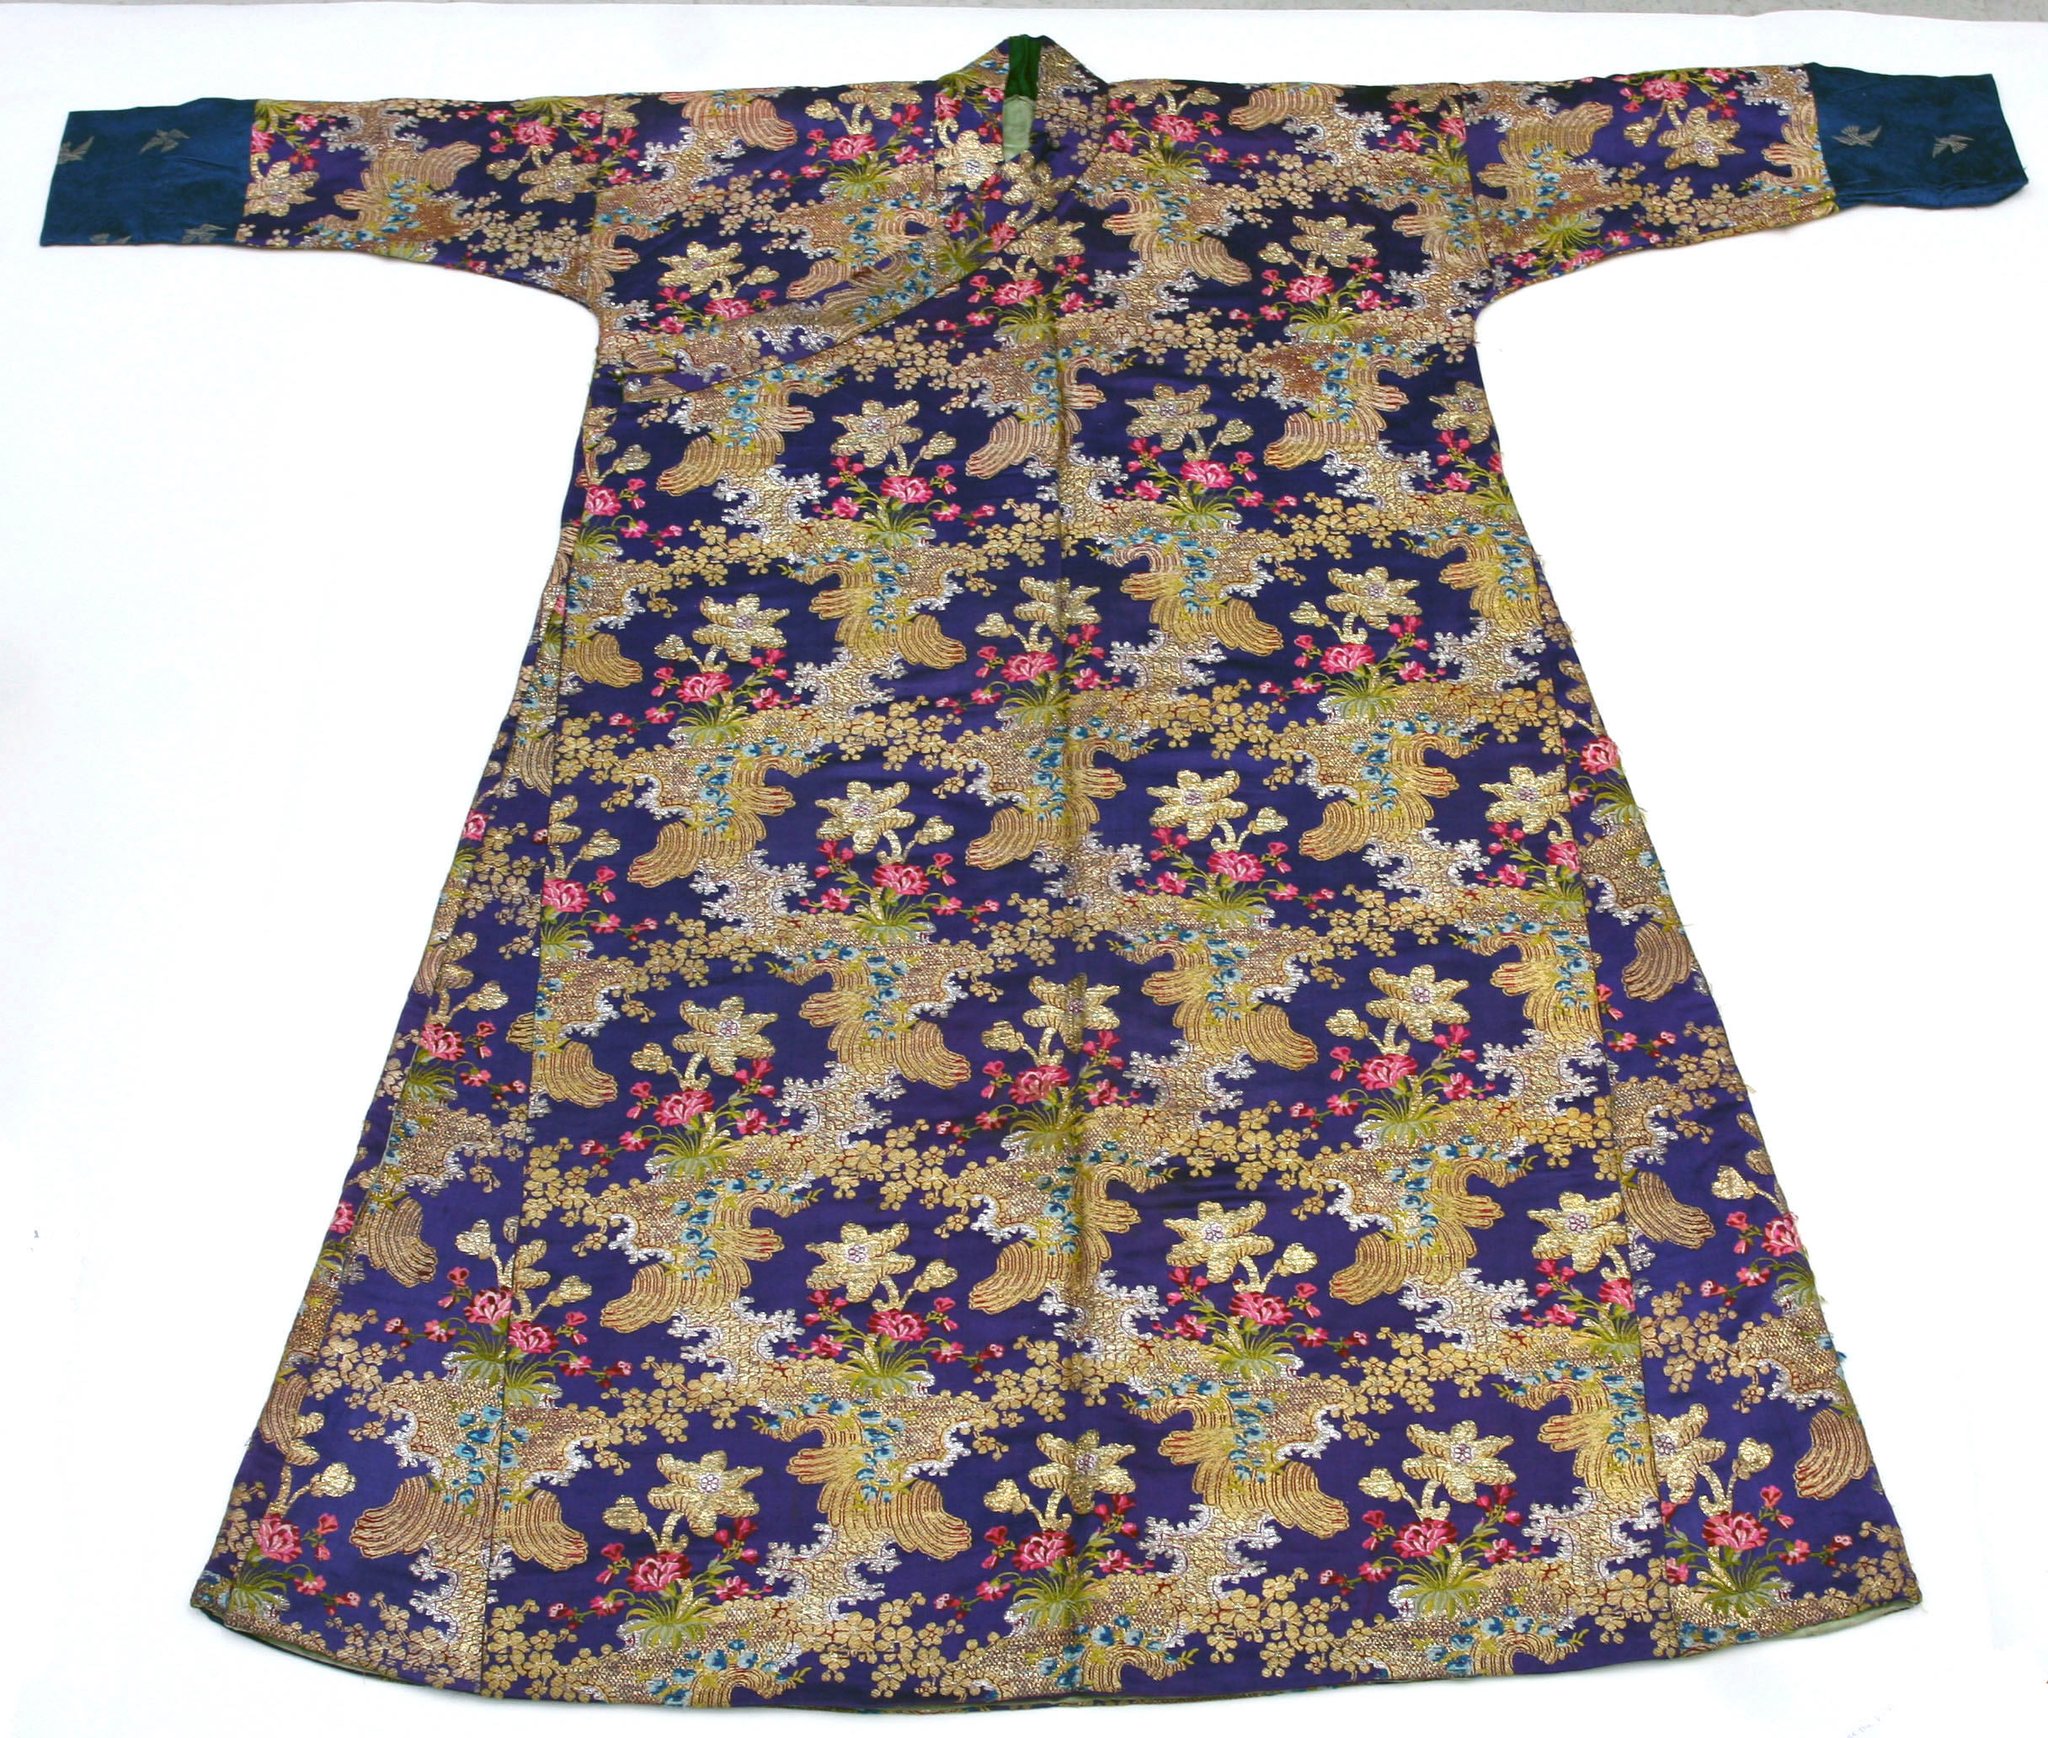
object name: chuba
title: Chuba made from Russian Silks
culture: tibetan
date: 1801-1900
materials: silk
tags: flowers